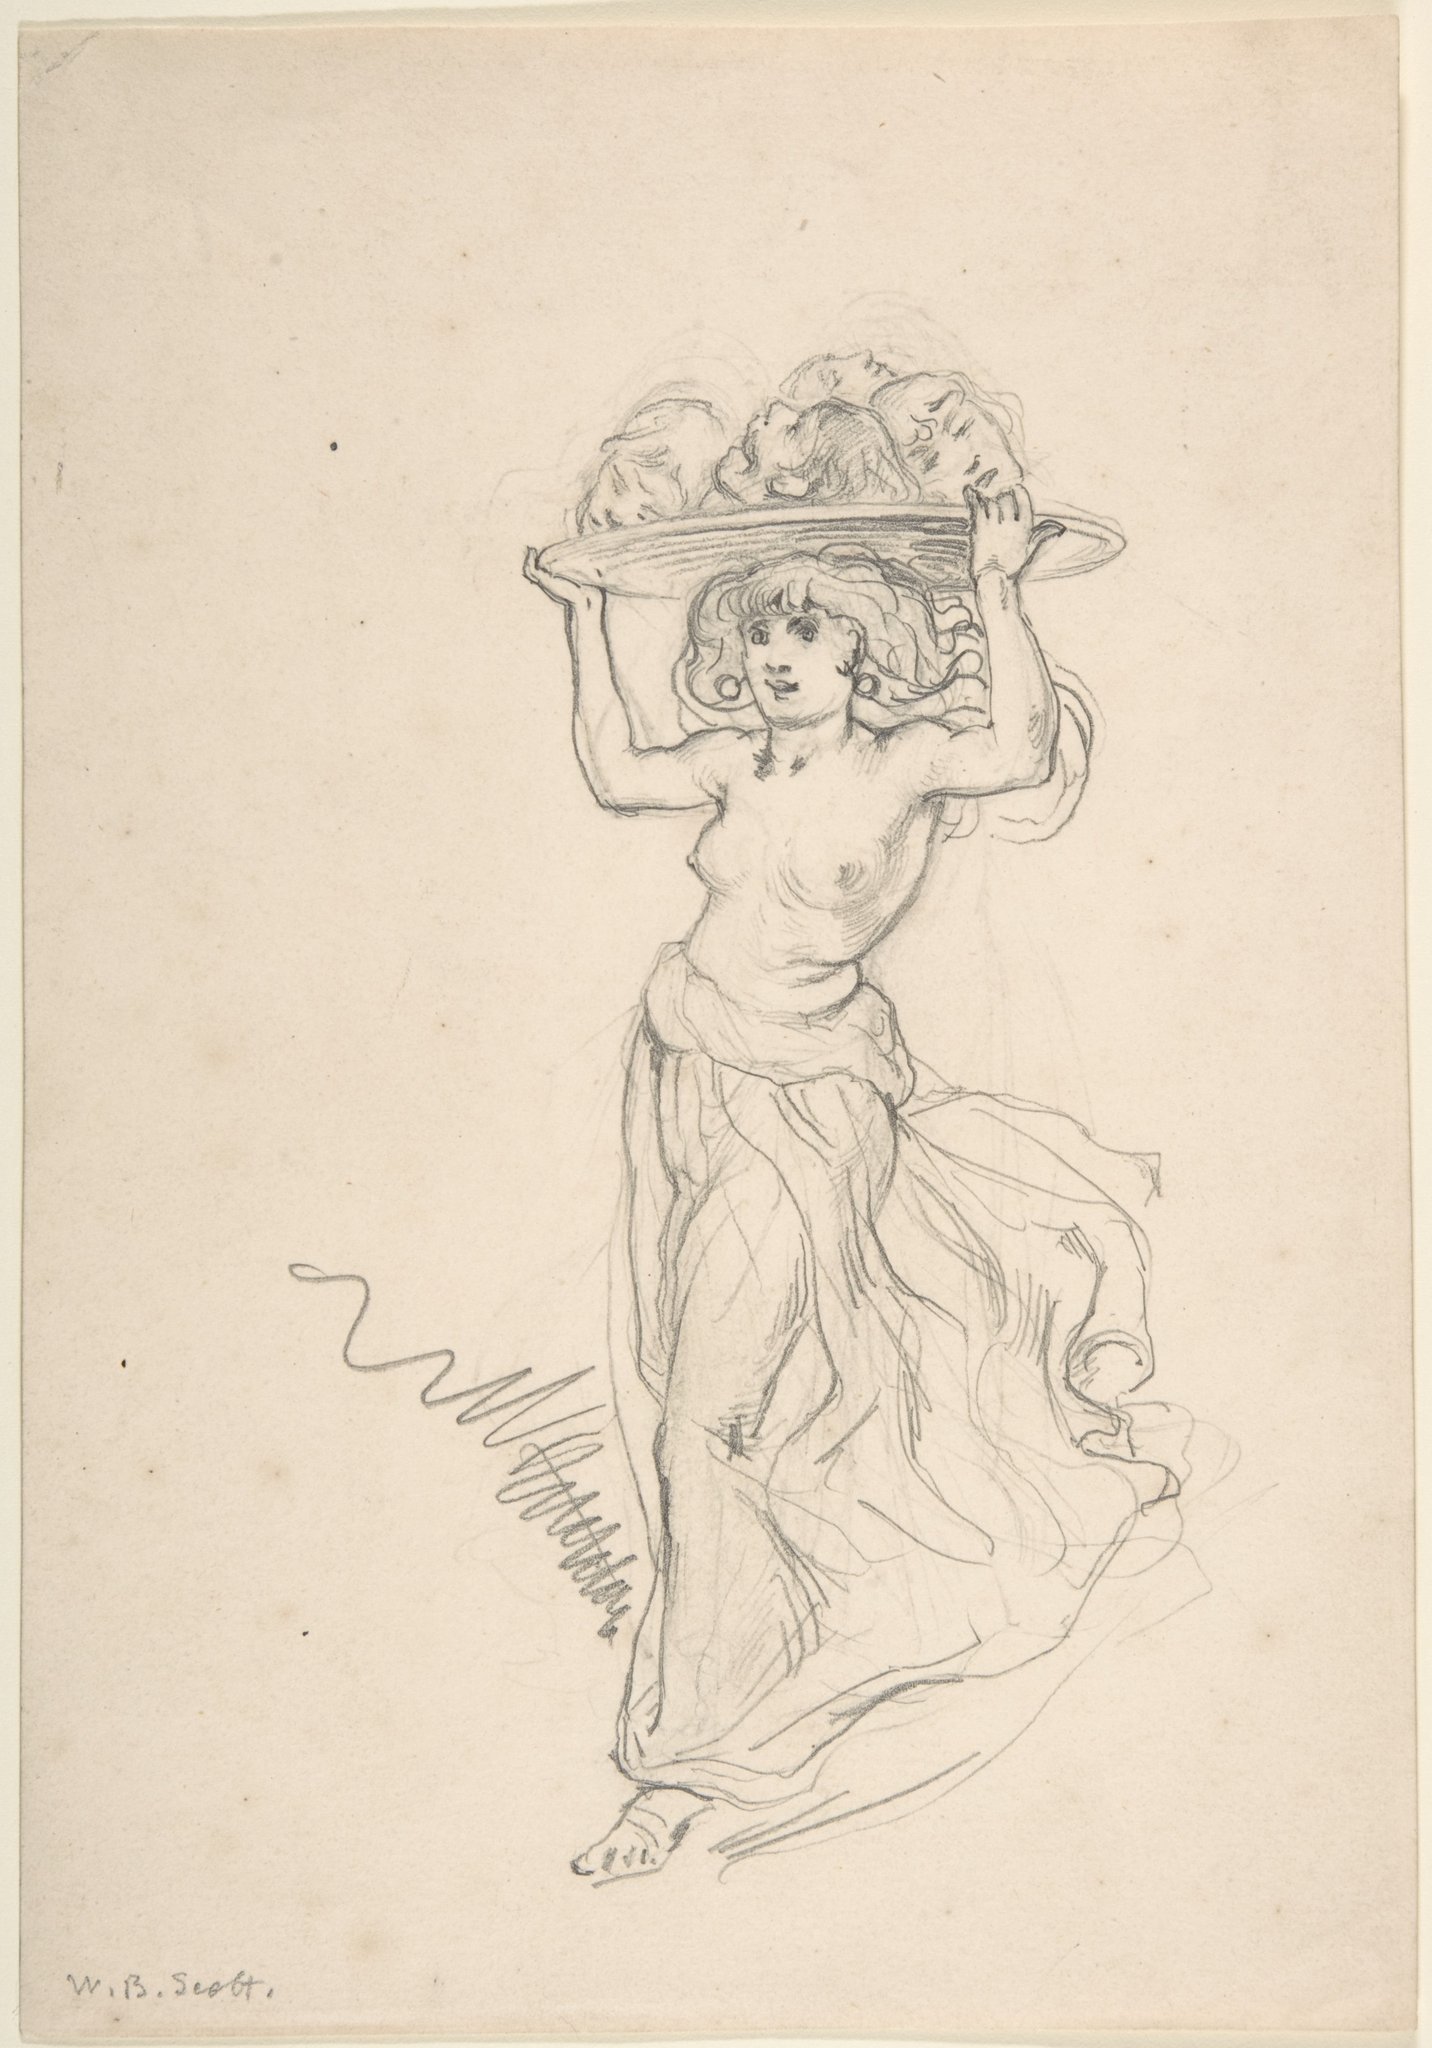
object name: drawing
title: Girl Carrying a Tray with Four Heads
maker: william bell scott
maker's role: artist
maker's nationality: british, scottish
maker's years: 1811-1890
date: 1876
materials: graphite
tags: heads,girls,female nudes,trays